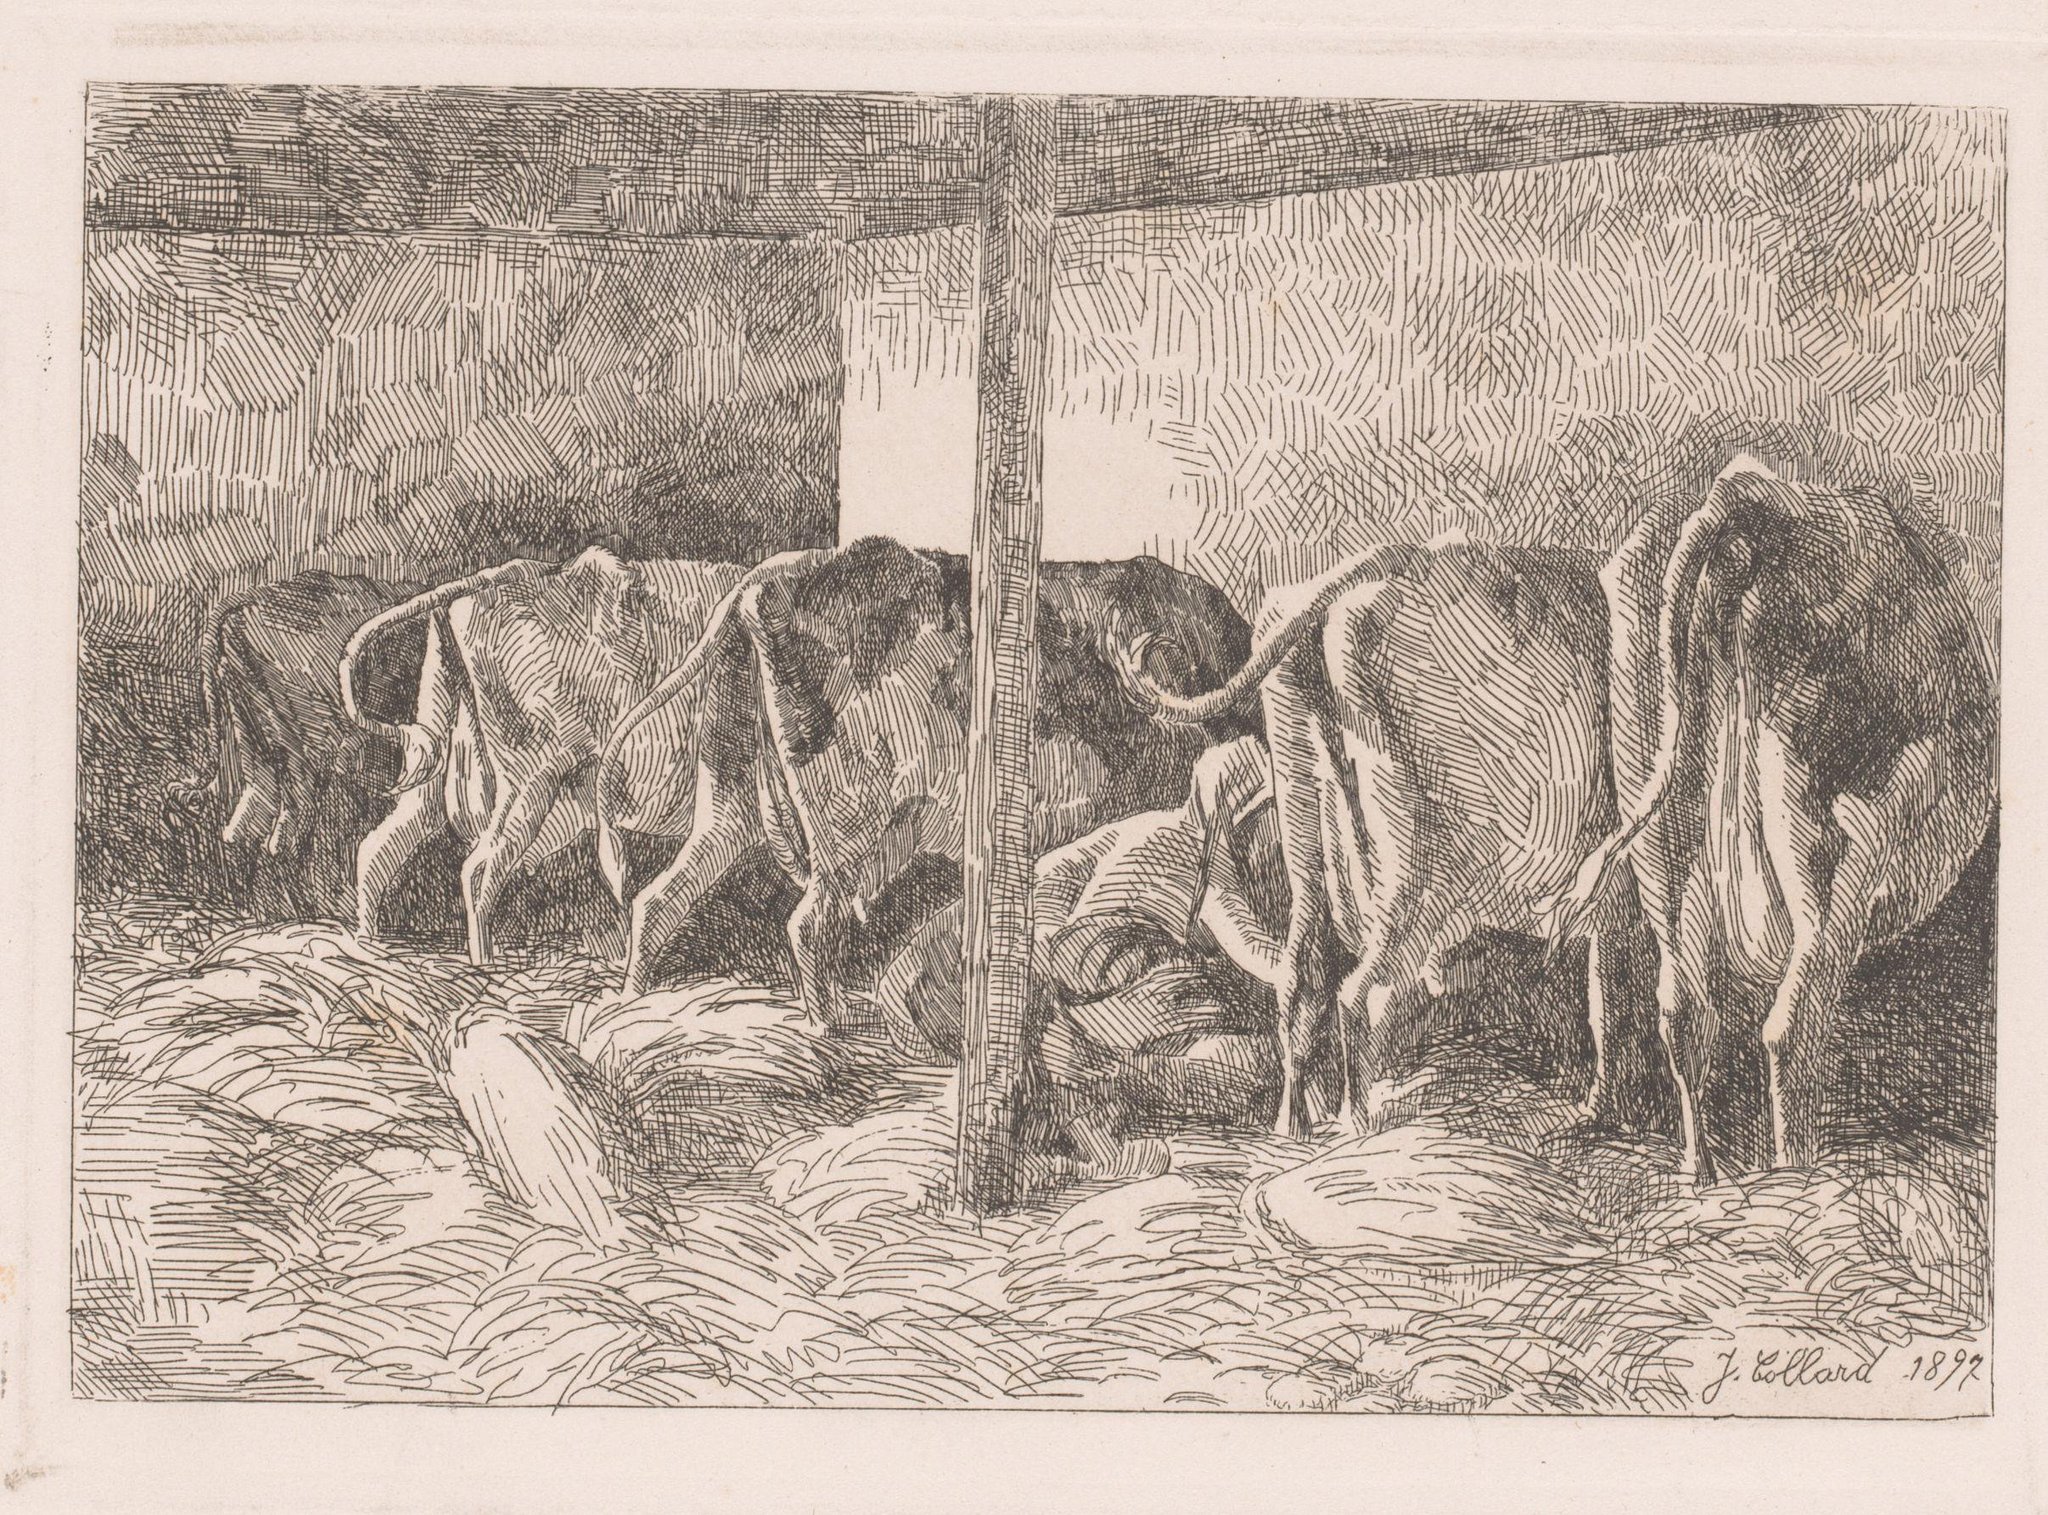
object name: print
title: Vrouw melkt een koe in de stal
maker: jean collard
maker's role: print maker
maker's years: 1881-1951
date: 1897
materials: paper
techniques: etching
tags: barn, cow, milking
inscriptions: collector's mark: Lugt 2228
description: De koeien in de stal zijn van achteren gezien.